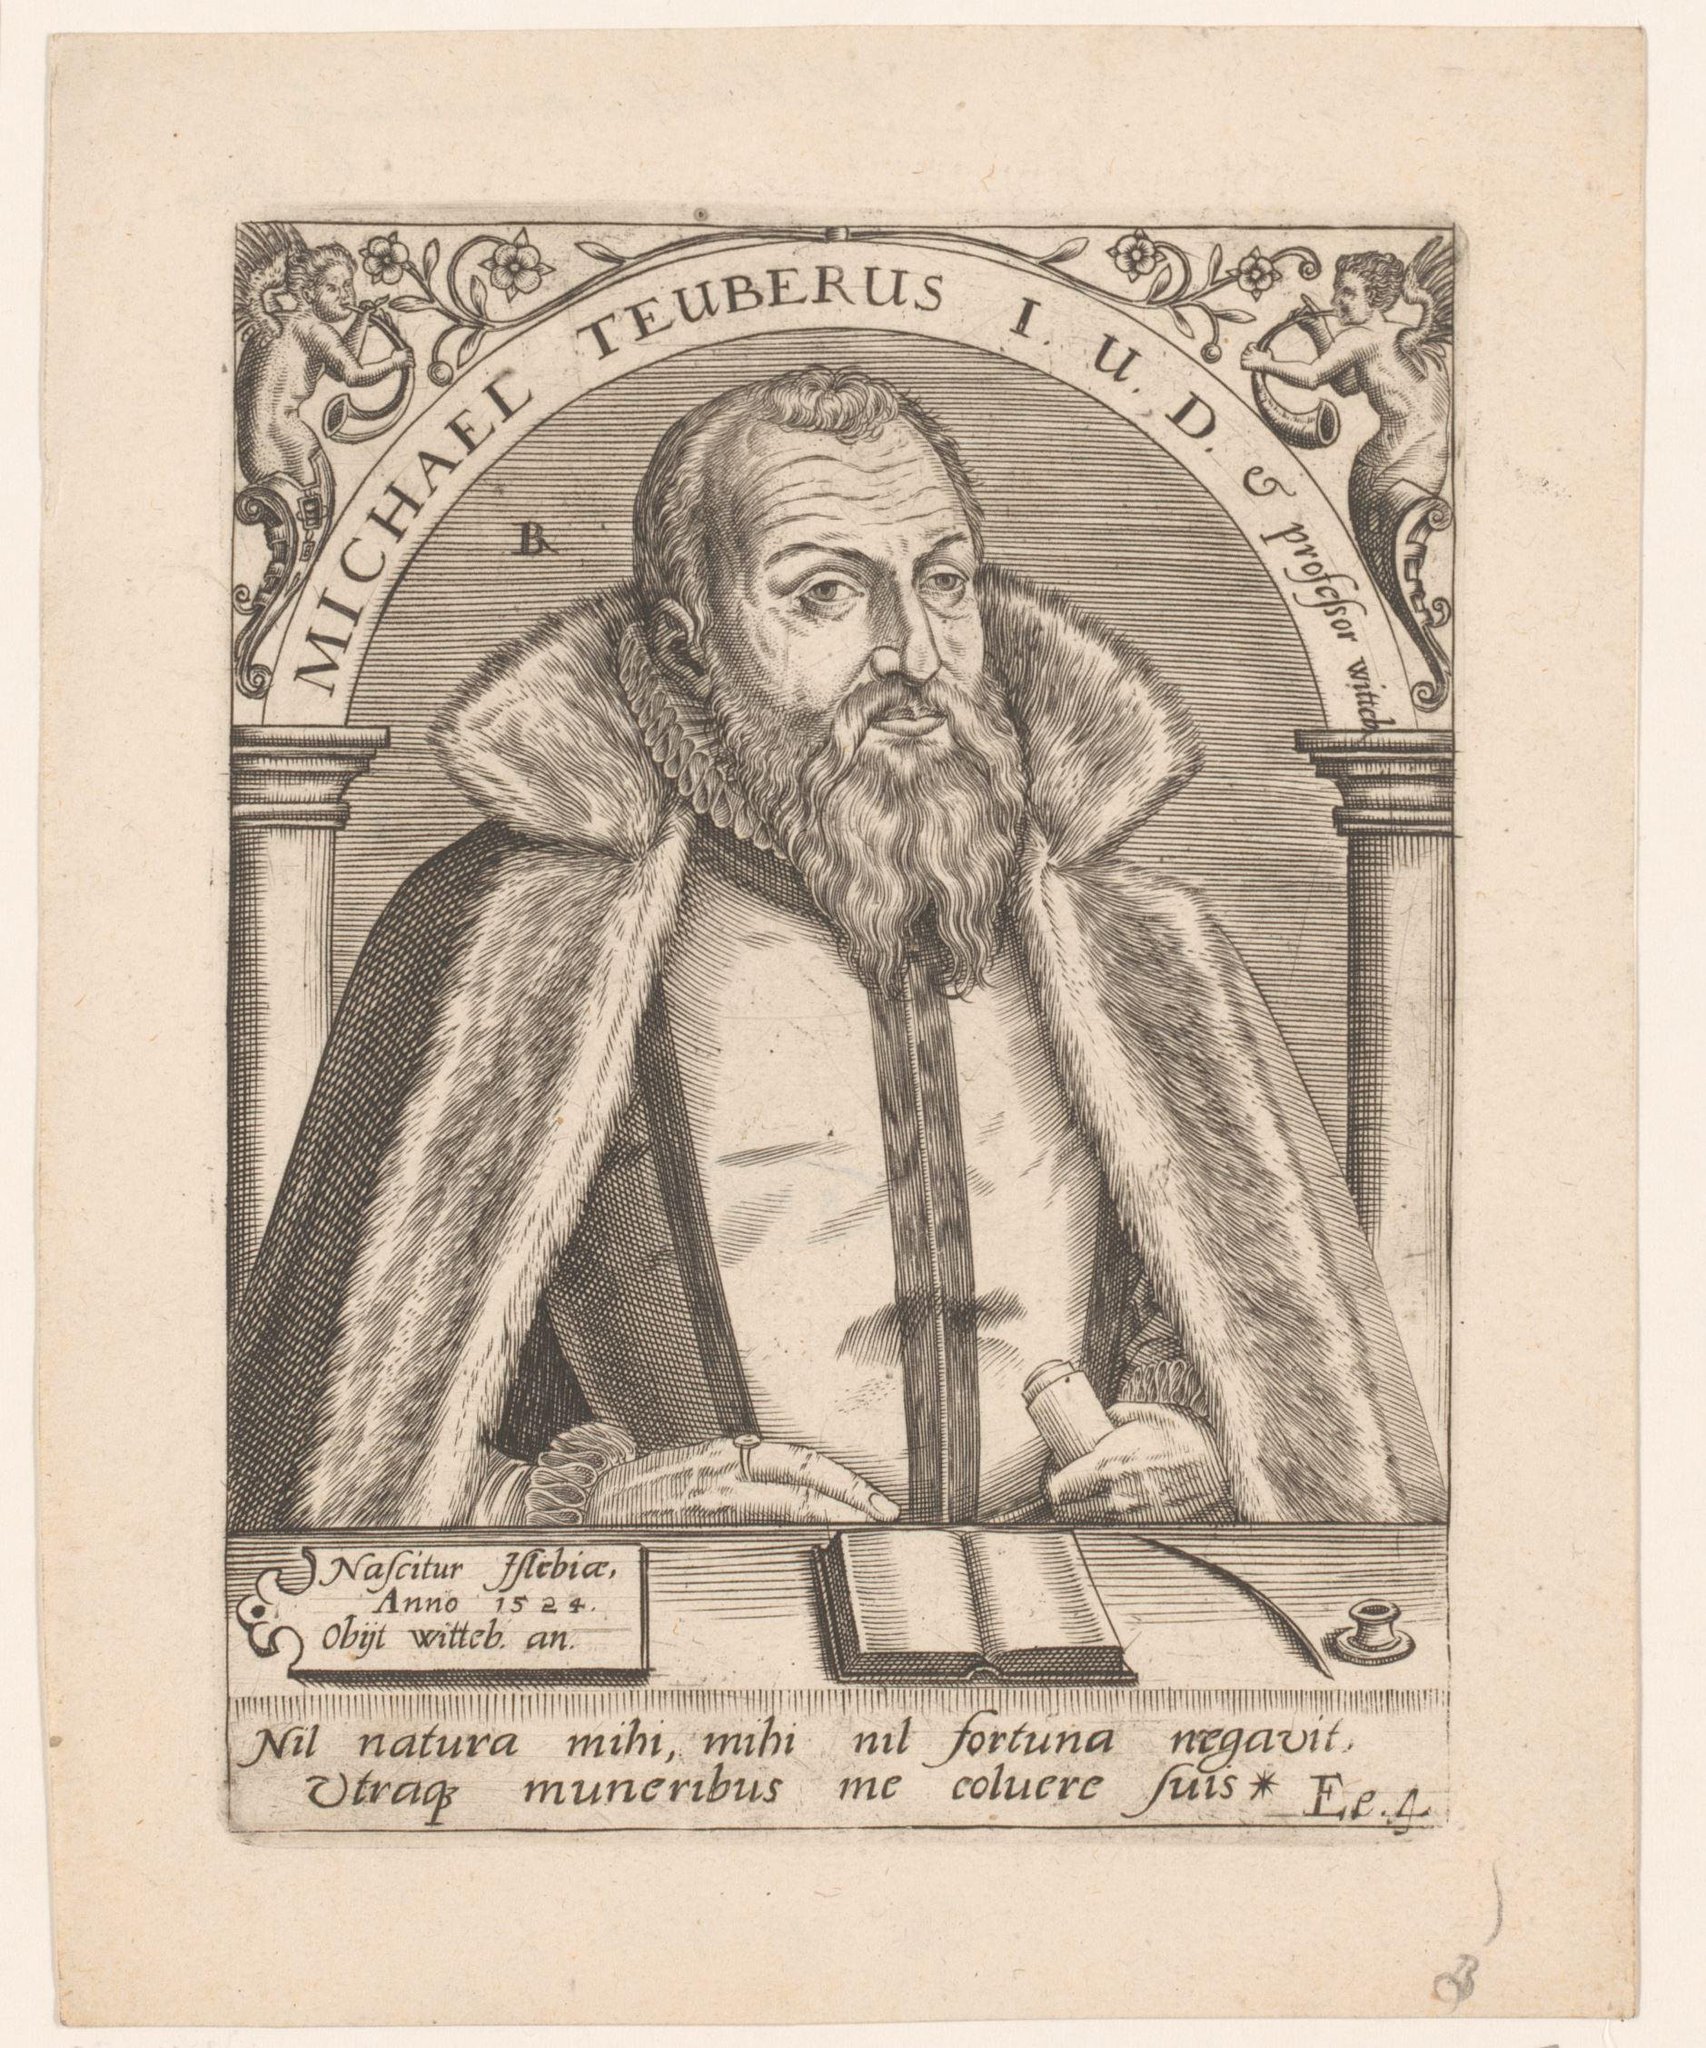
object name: print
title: Michael Teuberus I.u.D. & professor witteb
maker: robert boissard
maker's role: print maker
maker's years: 1570-1611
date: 1597-1599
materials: paper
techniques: engraving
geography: france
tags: ink-well, historical persons, book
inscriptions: collector's mark: Lugt 2228